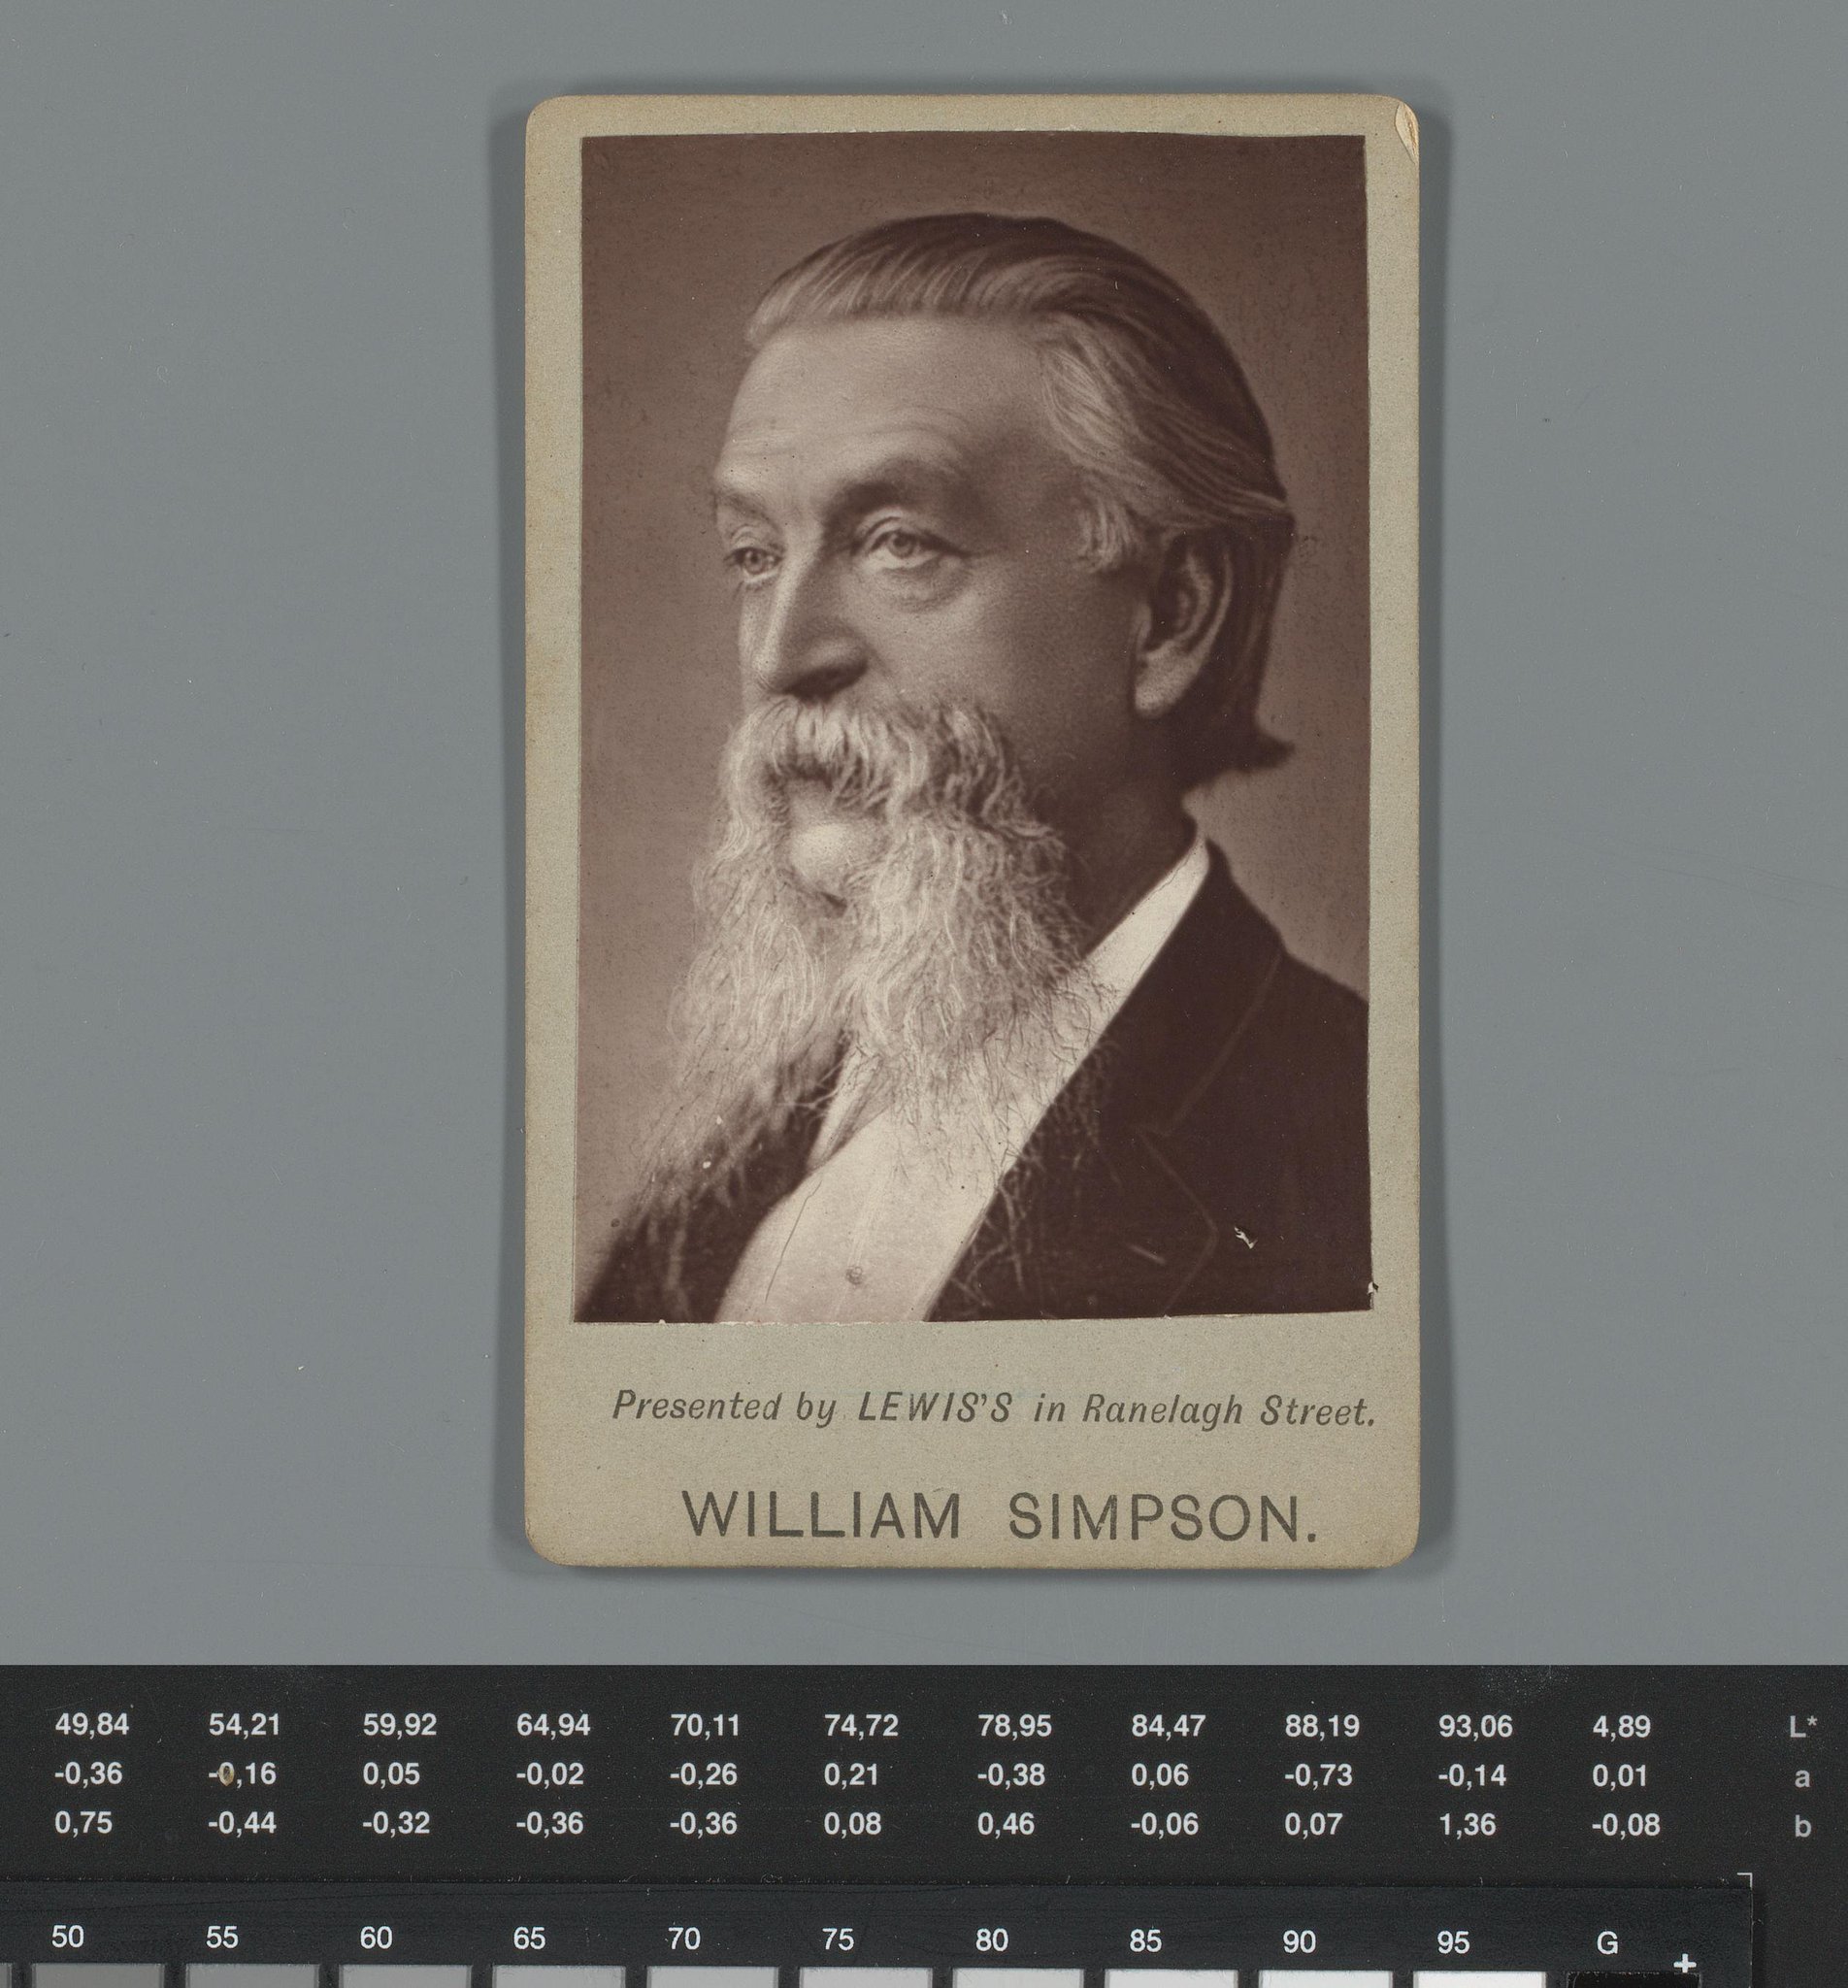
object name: carte de visite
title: Reclame voor Lewis's in Liverpool met portret van William Simpson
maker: Anonymous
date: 1880-1915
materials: cardboard, photographic support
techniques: carbon print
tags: advertising, historical persons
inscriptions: inscription: ‘PHOTOGRAPH/ OF OUR/ LATE TOWNSMAN,/ WILLIAM SIMPSON,/ PRESENTED BY/ LEWIS'S/ IN/ RANELAGH STREET.’